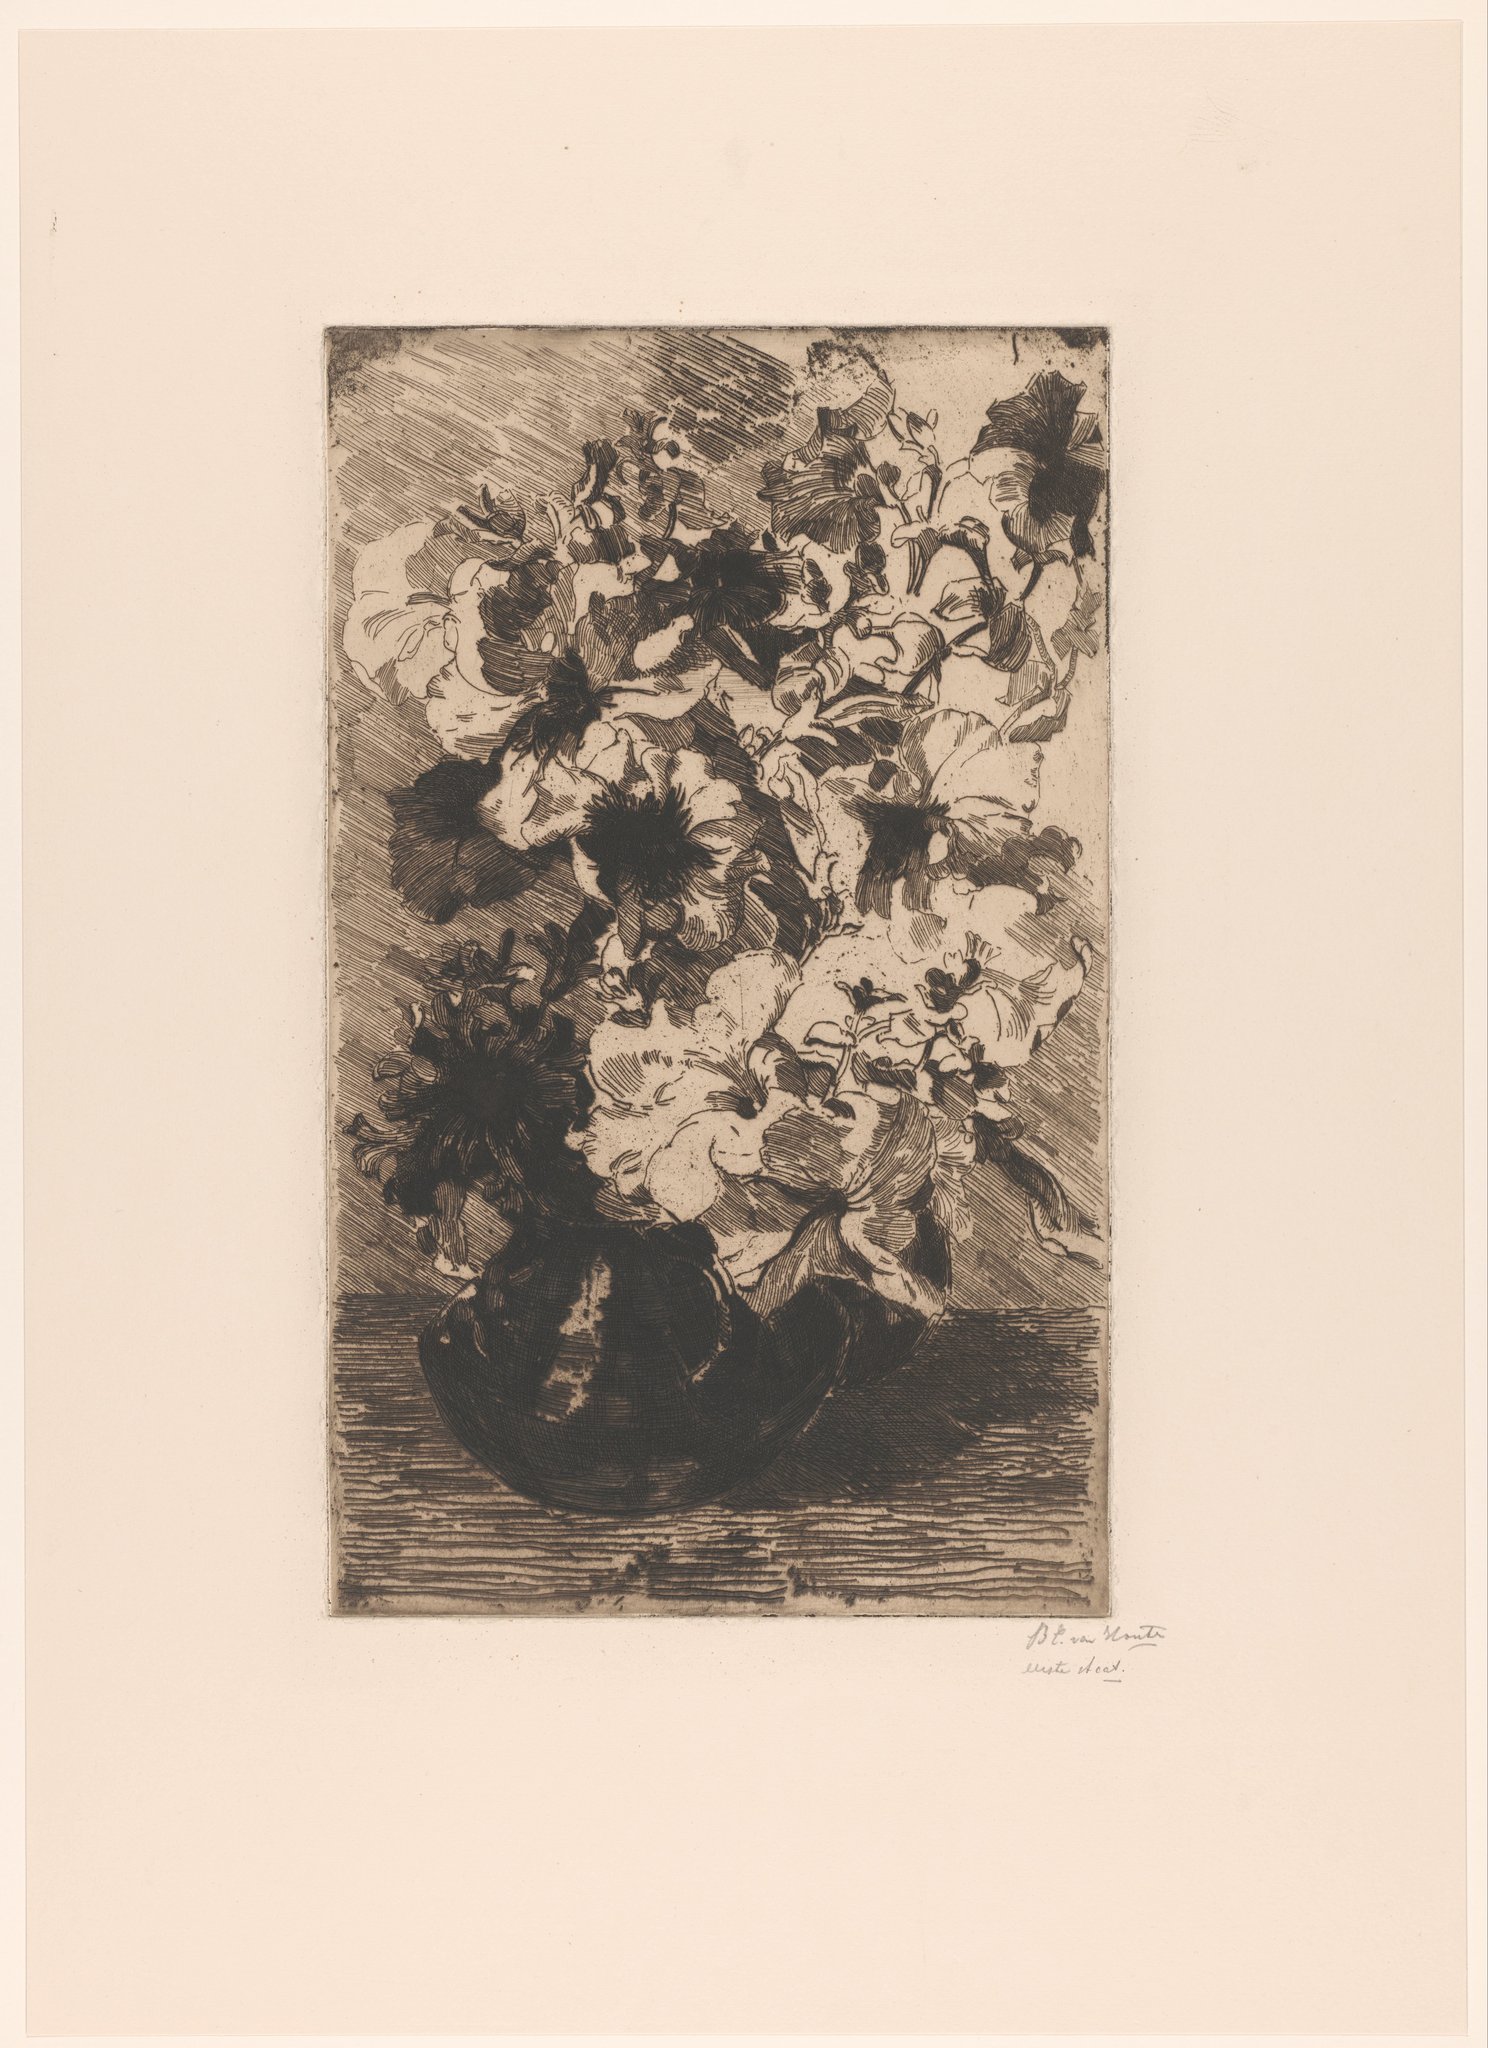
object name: print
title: Petunia's in een kan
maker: barbara elisabeth van houten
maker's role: draughtsman, print maker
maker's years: 1862-1950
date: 1872-1950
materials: paper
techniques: etching, intaglio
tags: flowers: petunia, flowers in a vase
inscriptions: inscription: ‘14 petunias eerste staat. niet exposeren zonder tweede staat.’, collector's mark: Lugt 2228